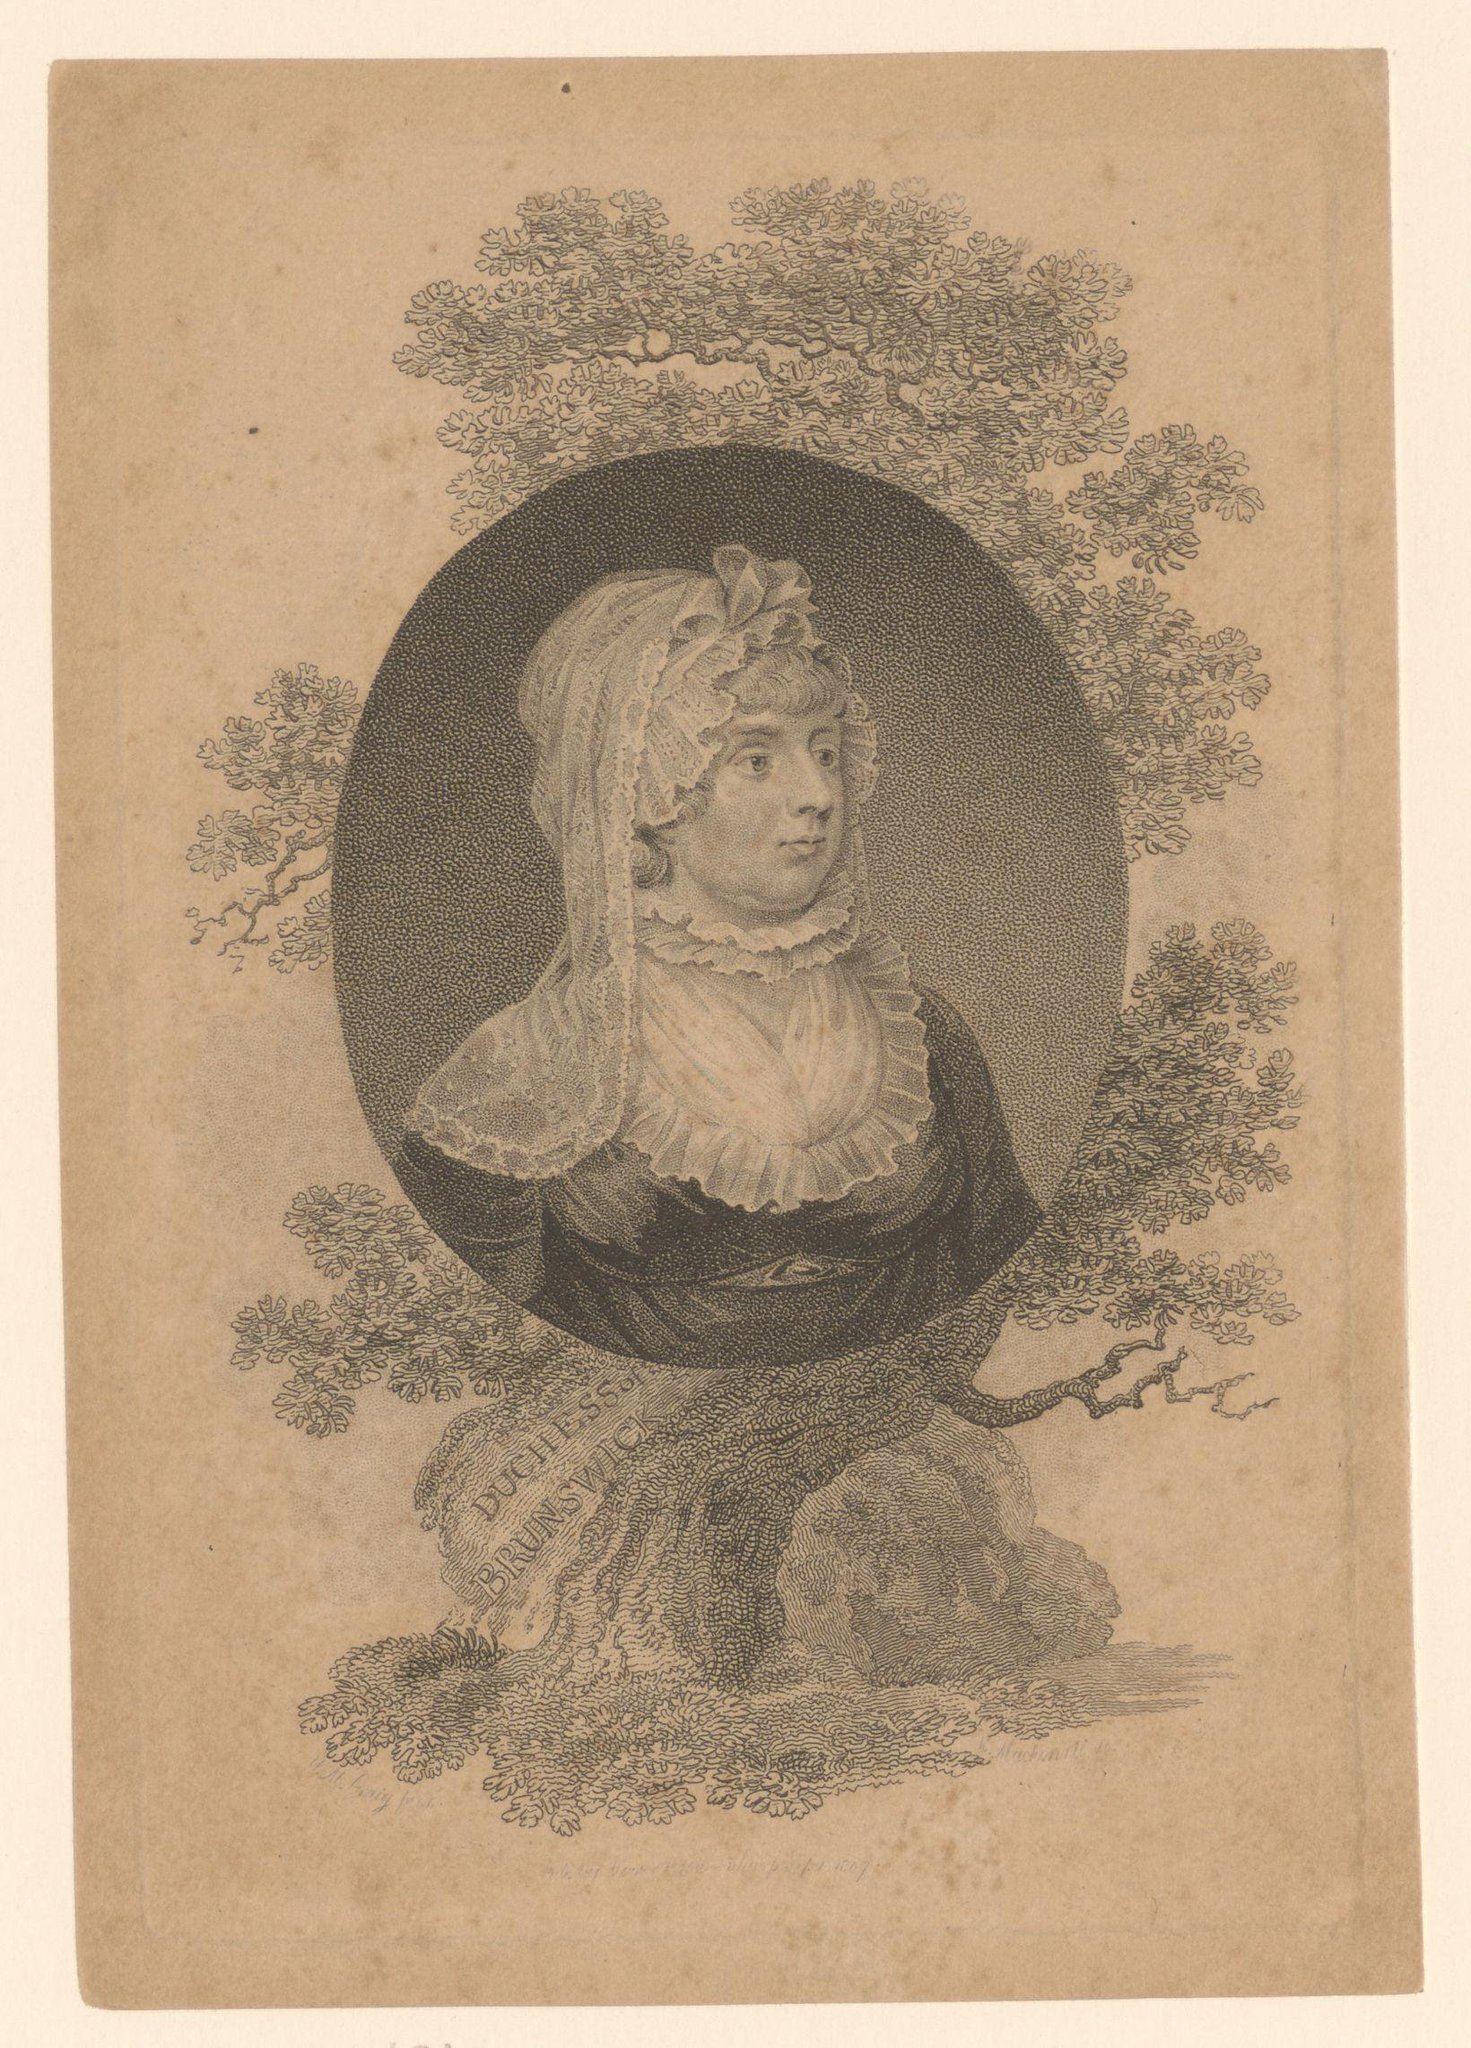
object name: print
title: Portret van Augusta Caroline van Brunswijk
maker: k. mackenzie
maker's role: print maker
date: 1807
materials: paper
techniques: etching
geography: london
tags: historical persons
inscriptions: collector's mark: Lugt 2228